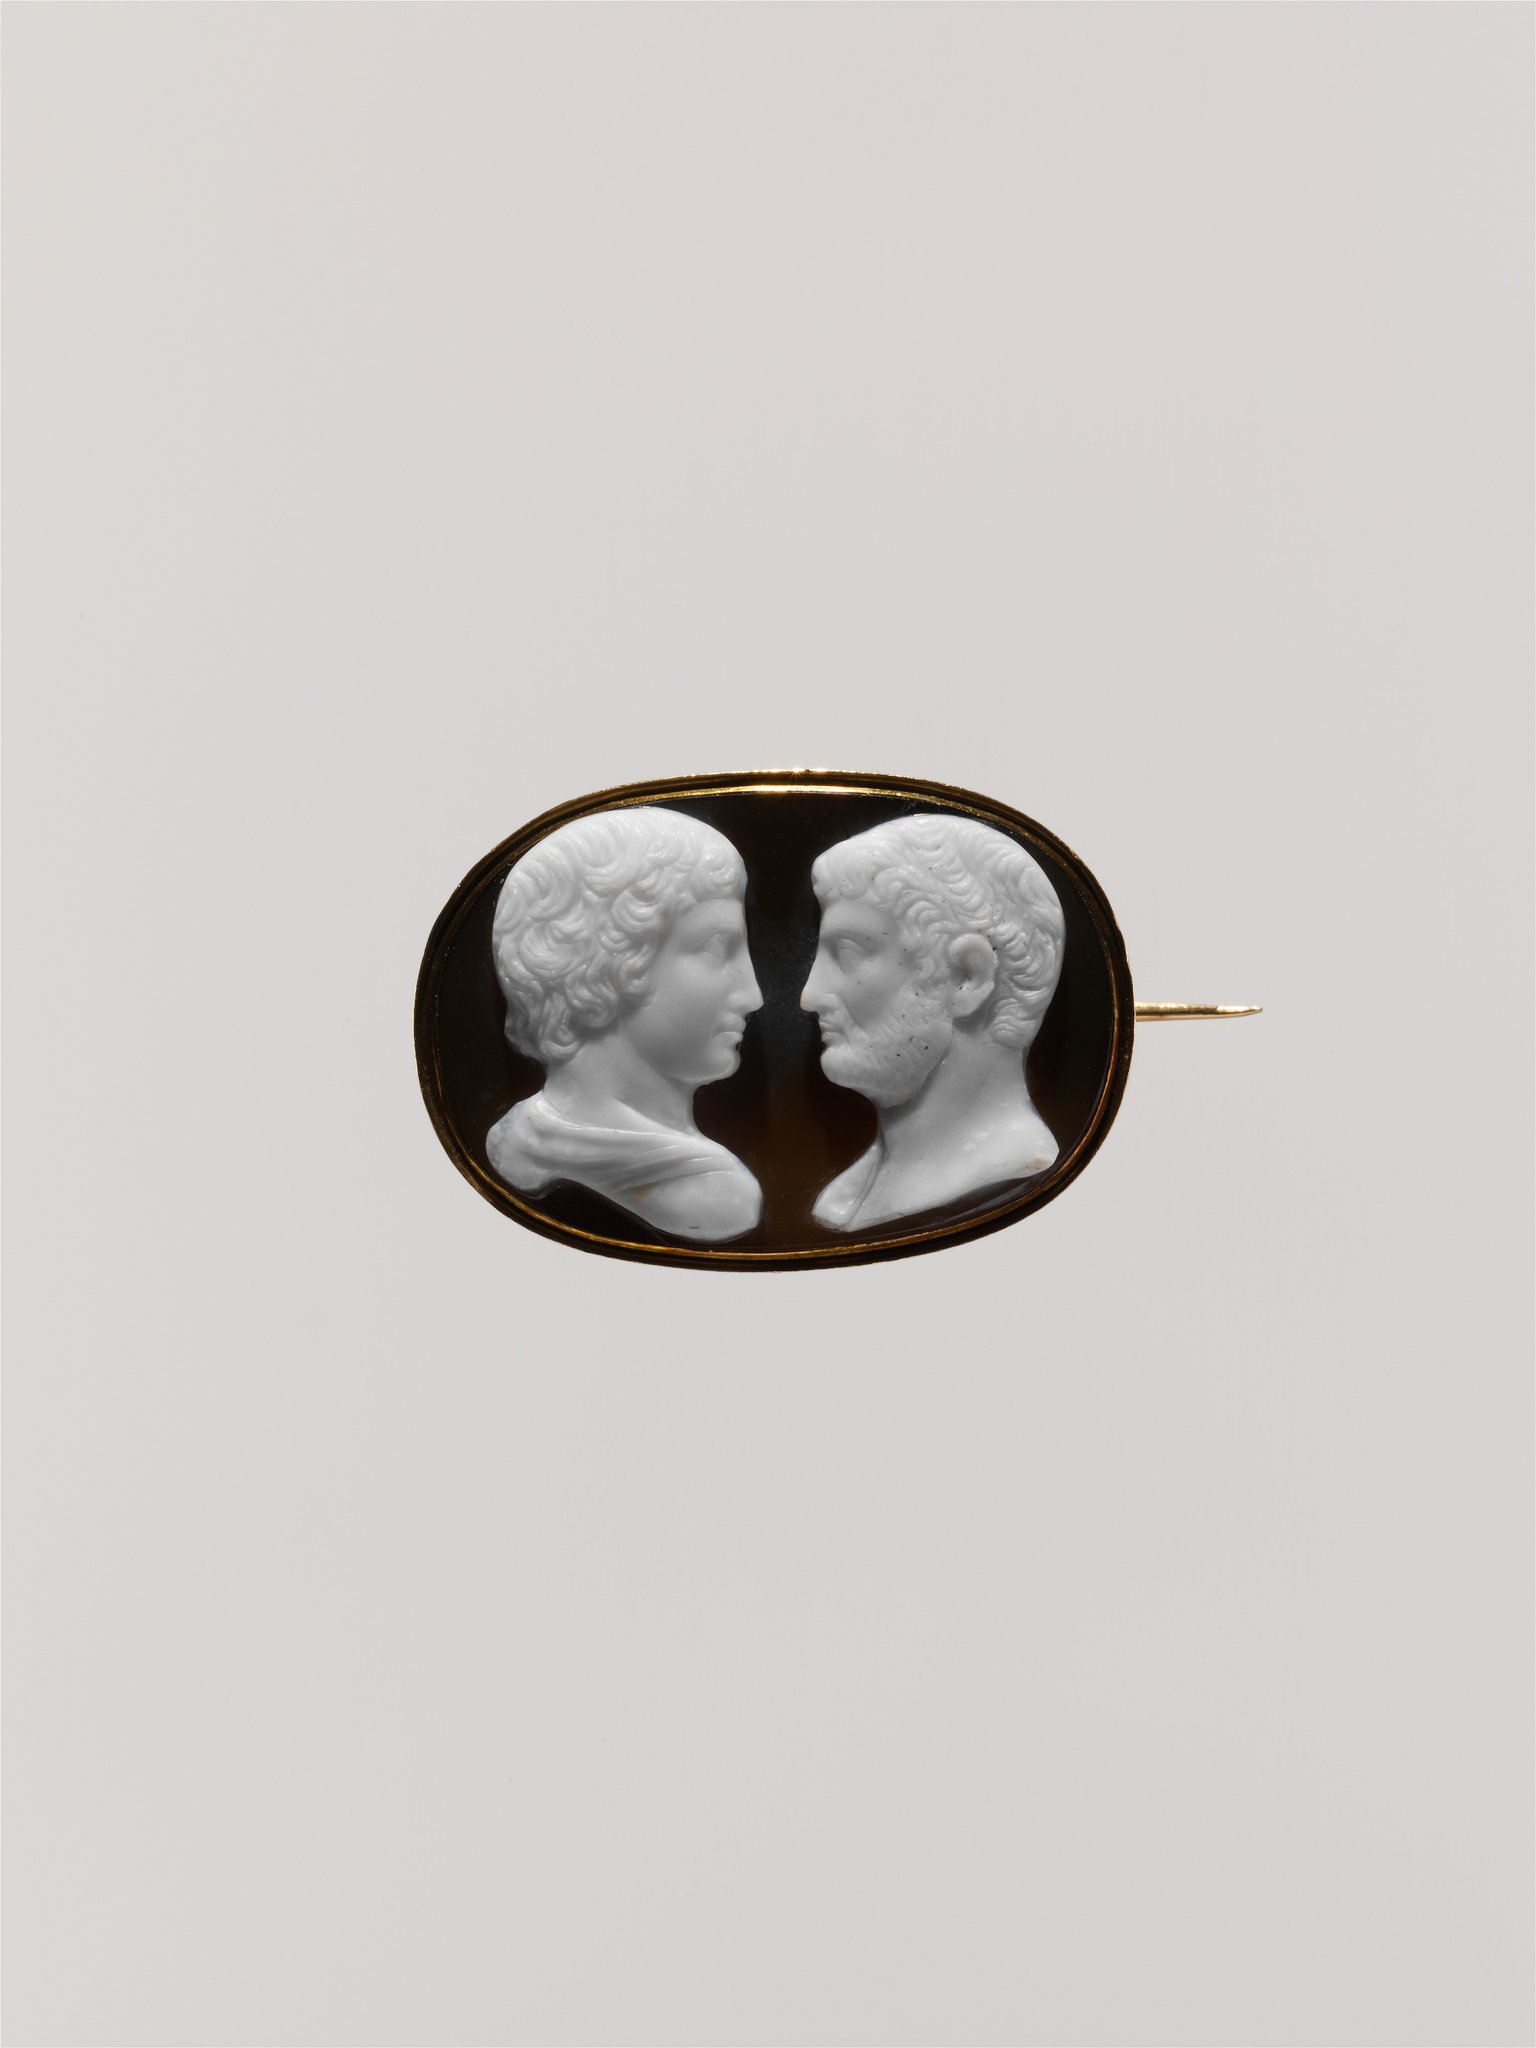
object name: cameo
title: Confronted busts of the Emperor Hadrian (Publius Aelius Hadrianus, 76–138) and his favorite, Antinous (d. 130)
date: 1734-1766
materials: gold, gemstone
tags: men,profiles